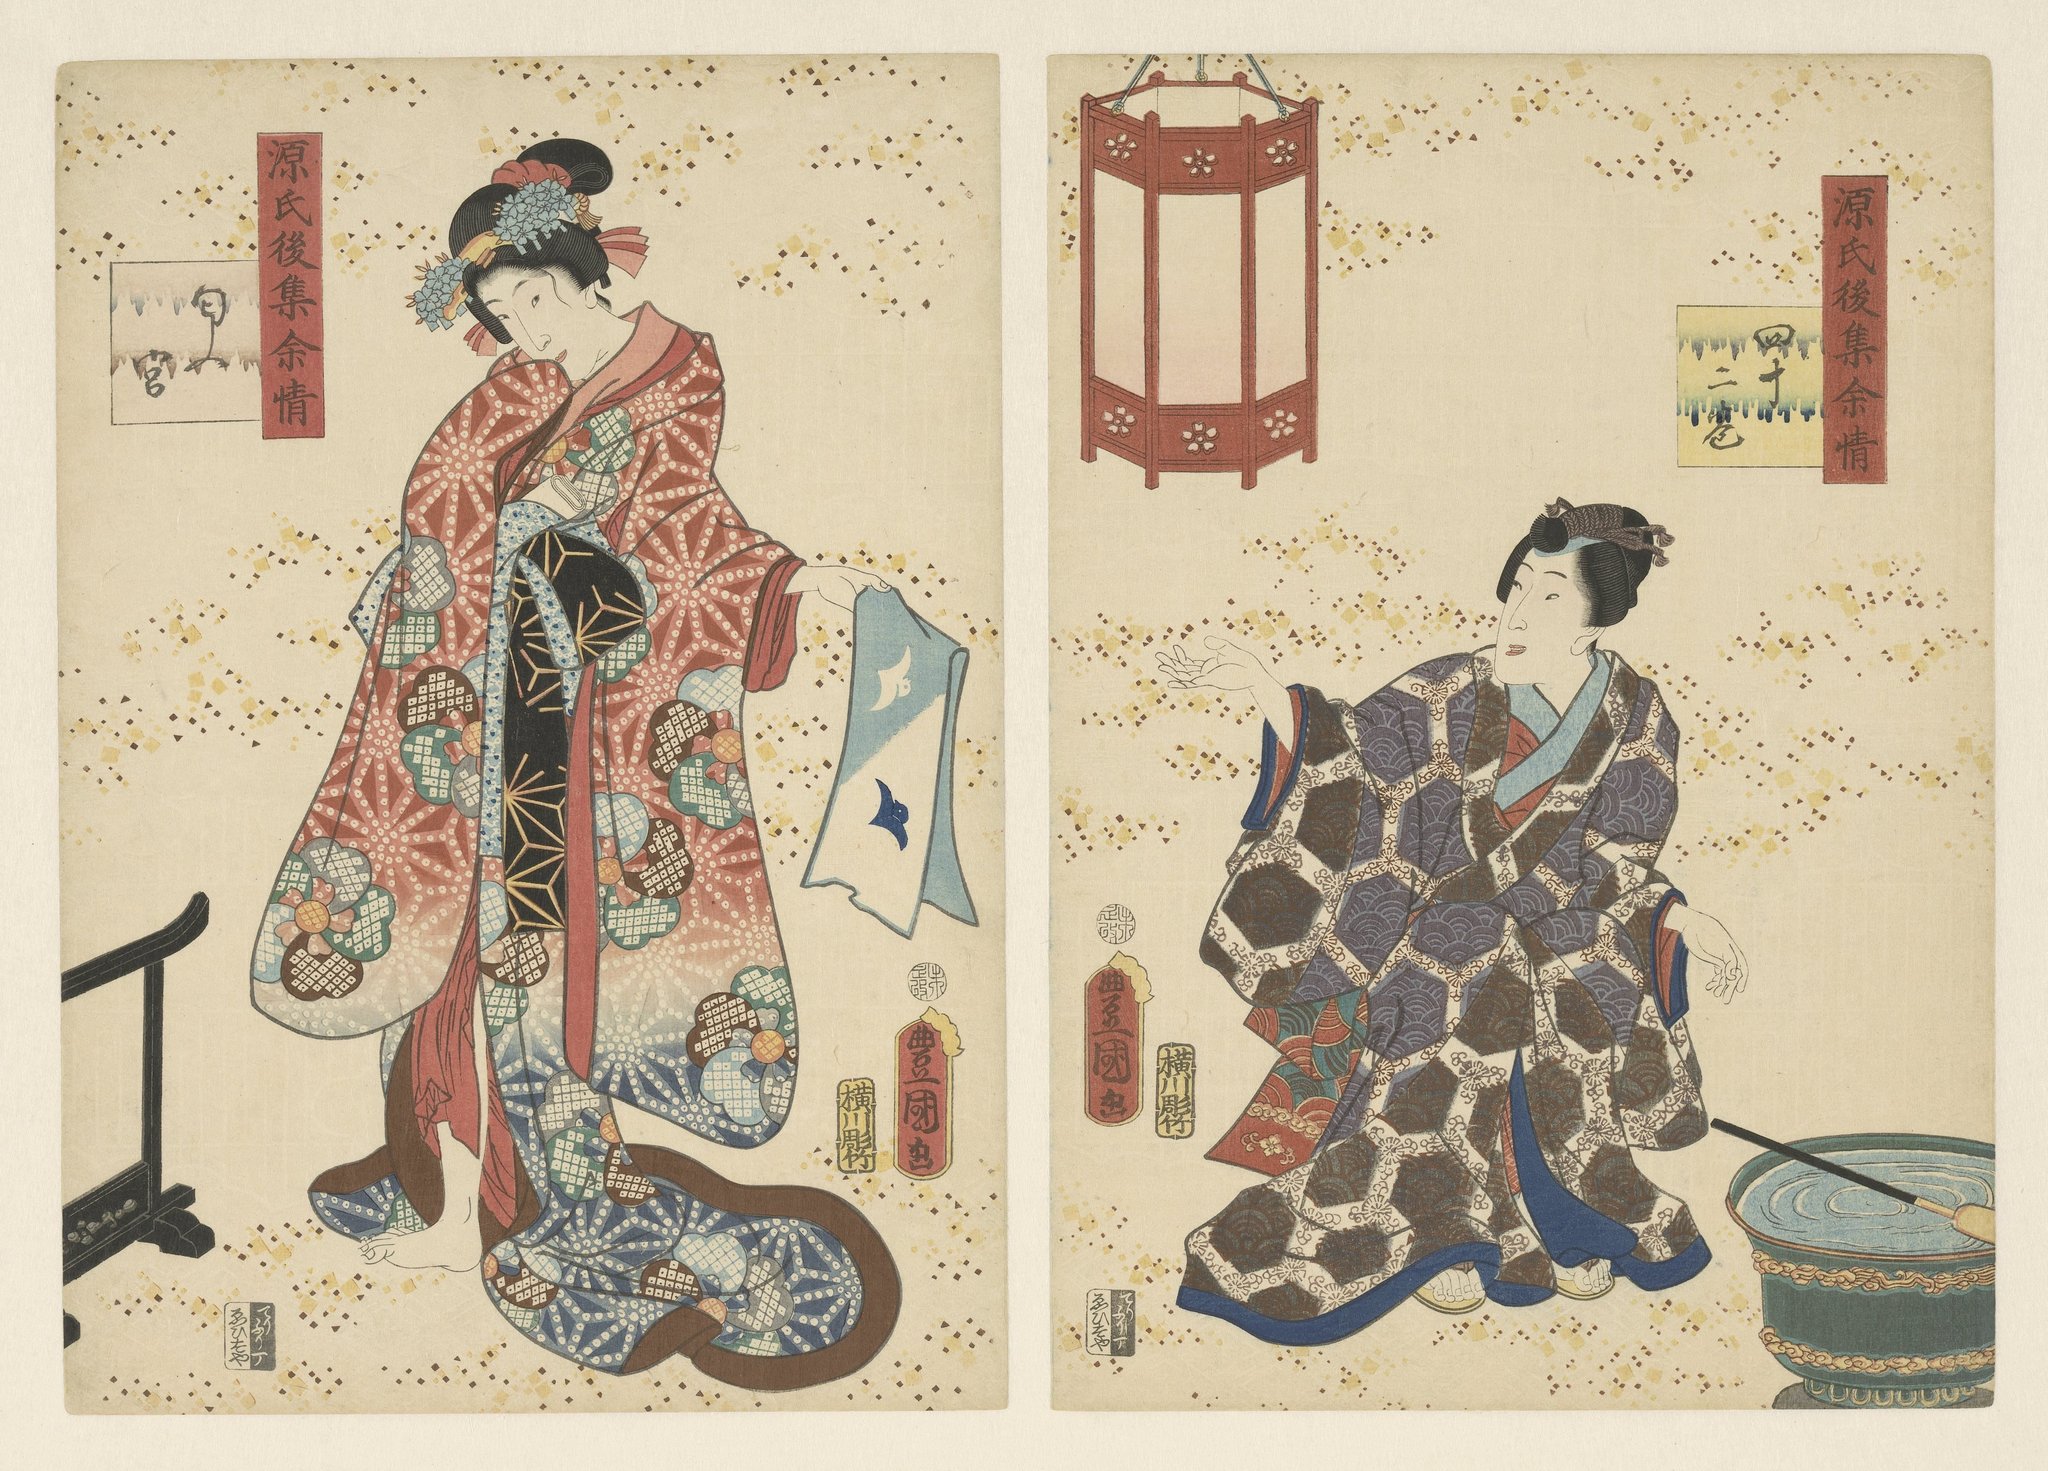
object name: print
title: Chapter 42, the perfumed prince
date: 1801-1859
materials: paper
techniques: woodcut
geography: tokyo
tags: adult woman, adult man, lantern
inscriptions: date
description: Een vrouw, op blote voeten, reikt een man zittend bij waterbekken een handdoek aan. De titel van dit diptiek is een woordspeling op hoofdstuk 4 van het Verhaal van Genji.